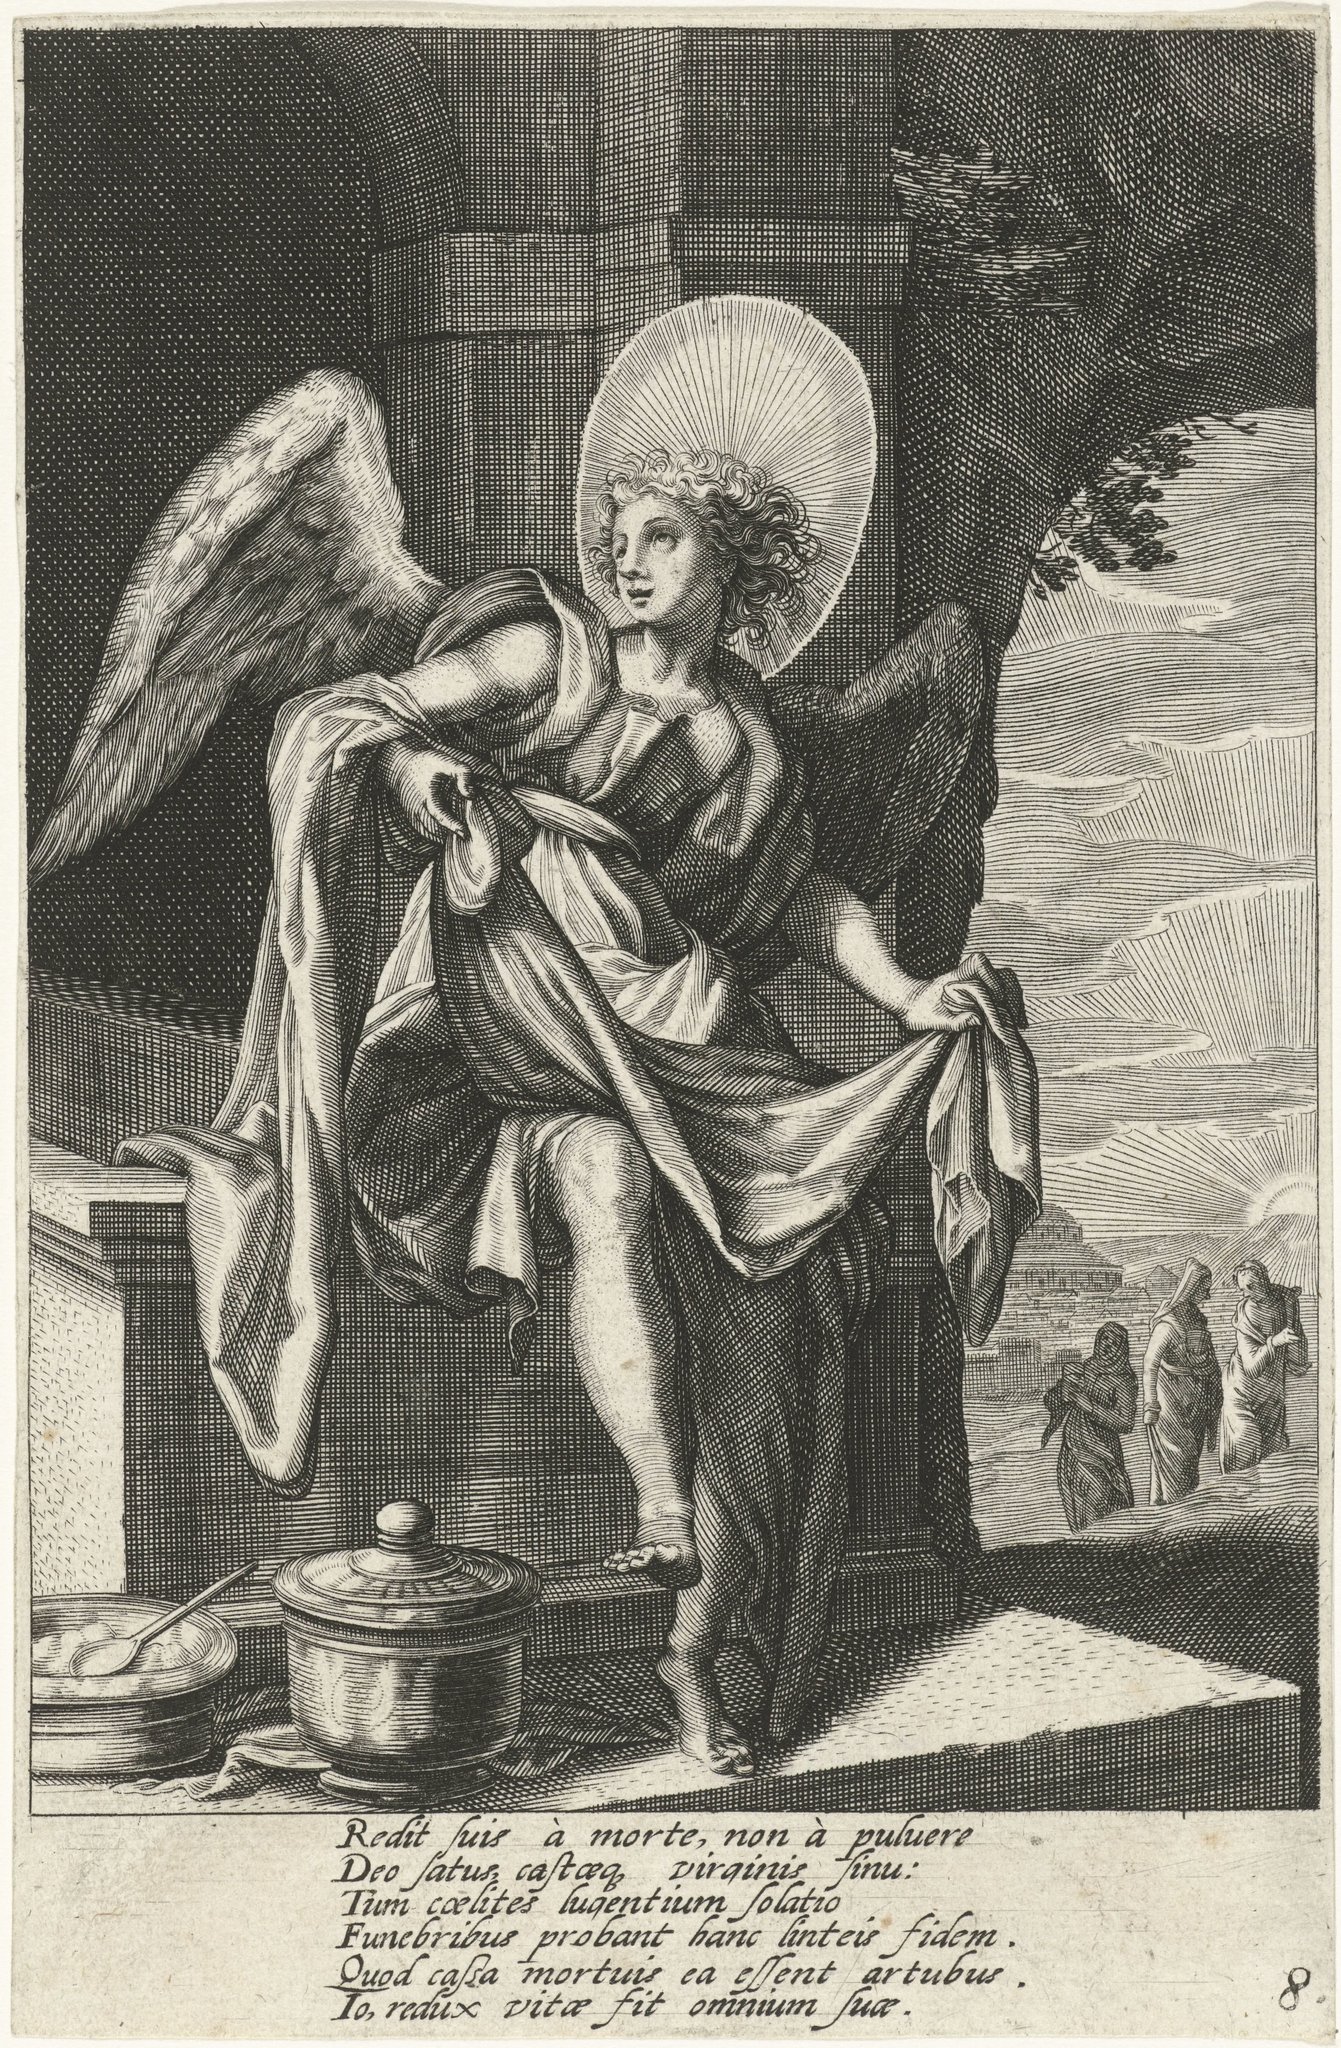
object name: print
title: Passiewerktuigen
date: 1608-1658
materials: paper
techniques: engraving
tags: the holy women (the three maries) on their way to or at the tomb, to anoint christ's body, virtues (holding instruments of the passion) ~ hierarchy of angels, the instruments of the passion and the five wounded limbs, angel(s) in or at the empty tomb of christ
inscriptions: collector's mark: Lugt 2228, collector's mark: Lugt 3791, collector's mark: Lugt 2760, number: ‘8’, caption: ‘Redit suis a morte...omnium suae.’, collector's mark: Lugt 1041c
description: Een engel zit op de rand van het lege graf van Christus, de lijkwade in de handen. Op de grond een schaal en een pot met deksel. Op de achtergrond de drie vrouwen op weg naar het graf.